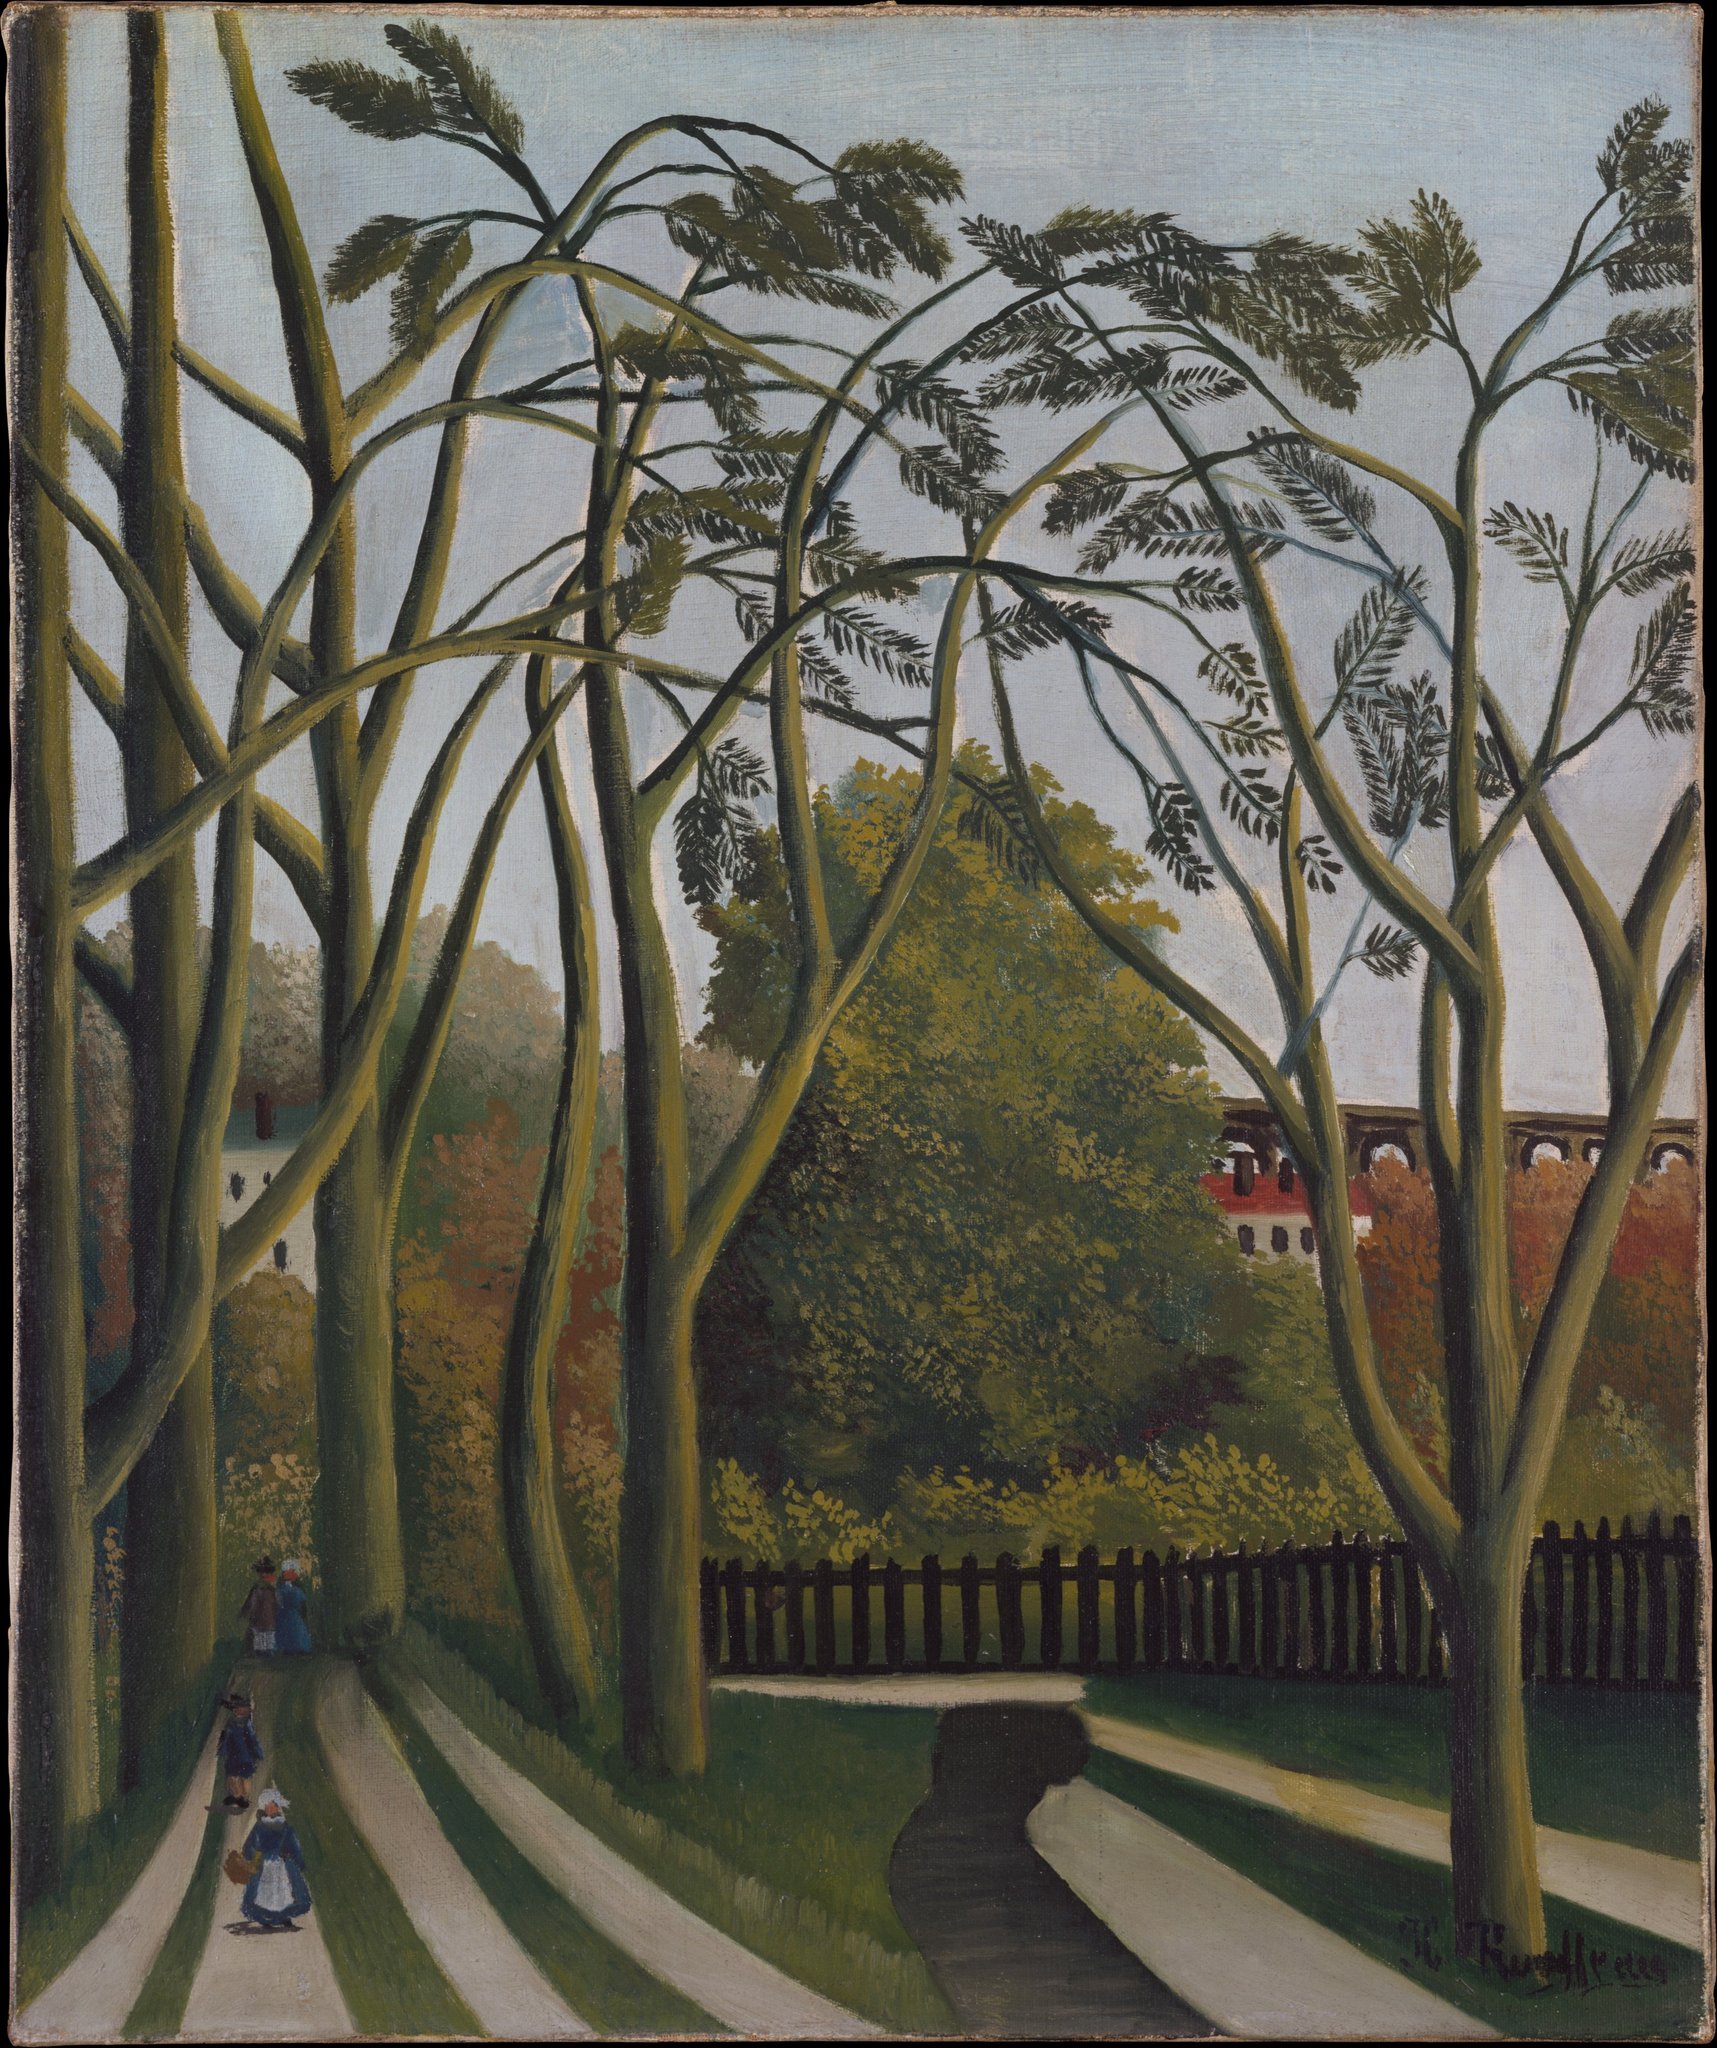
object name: painting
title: The Banks of the Bièvre near Bicêtre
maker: henri rousseau (le douanier)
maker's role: artist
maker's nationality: french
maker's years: 1844-1910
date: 1908-1909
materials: canvas, oil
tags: forests